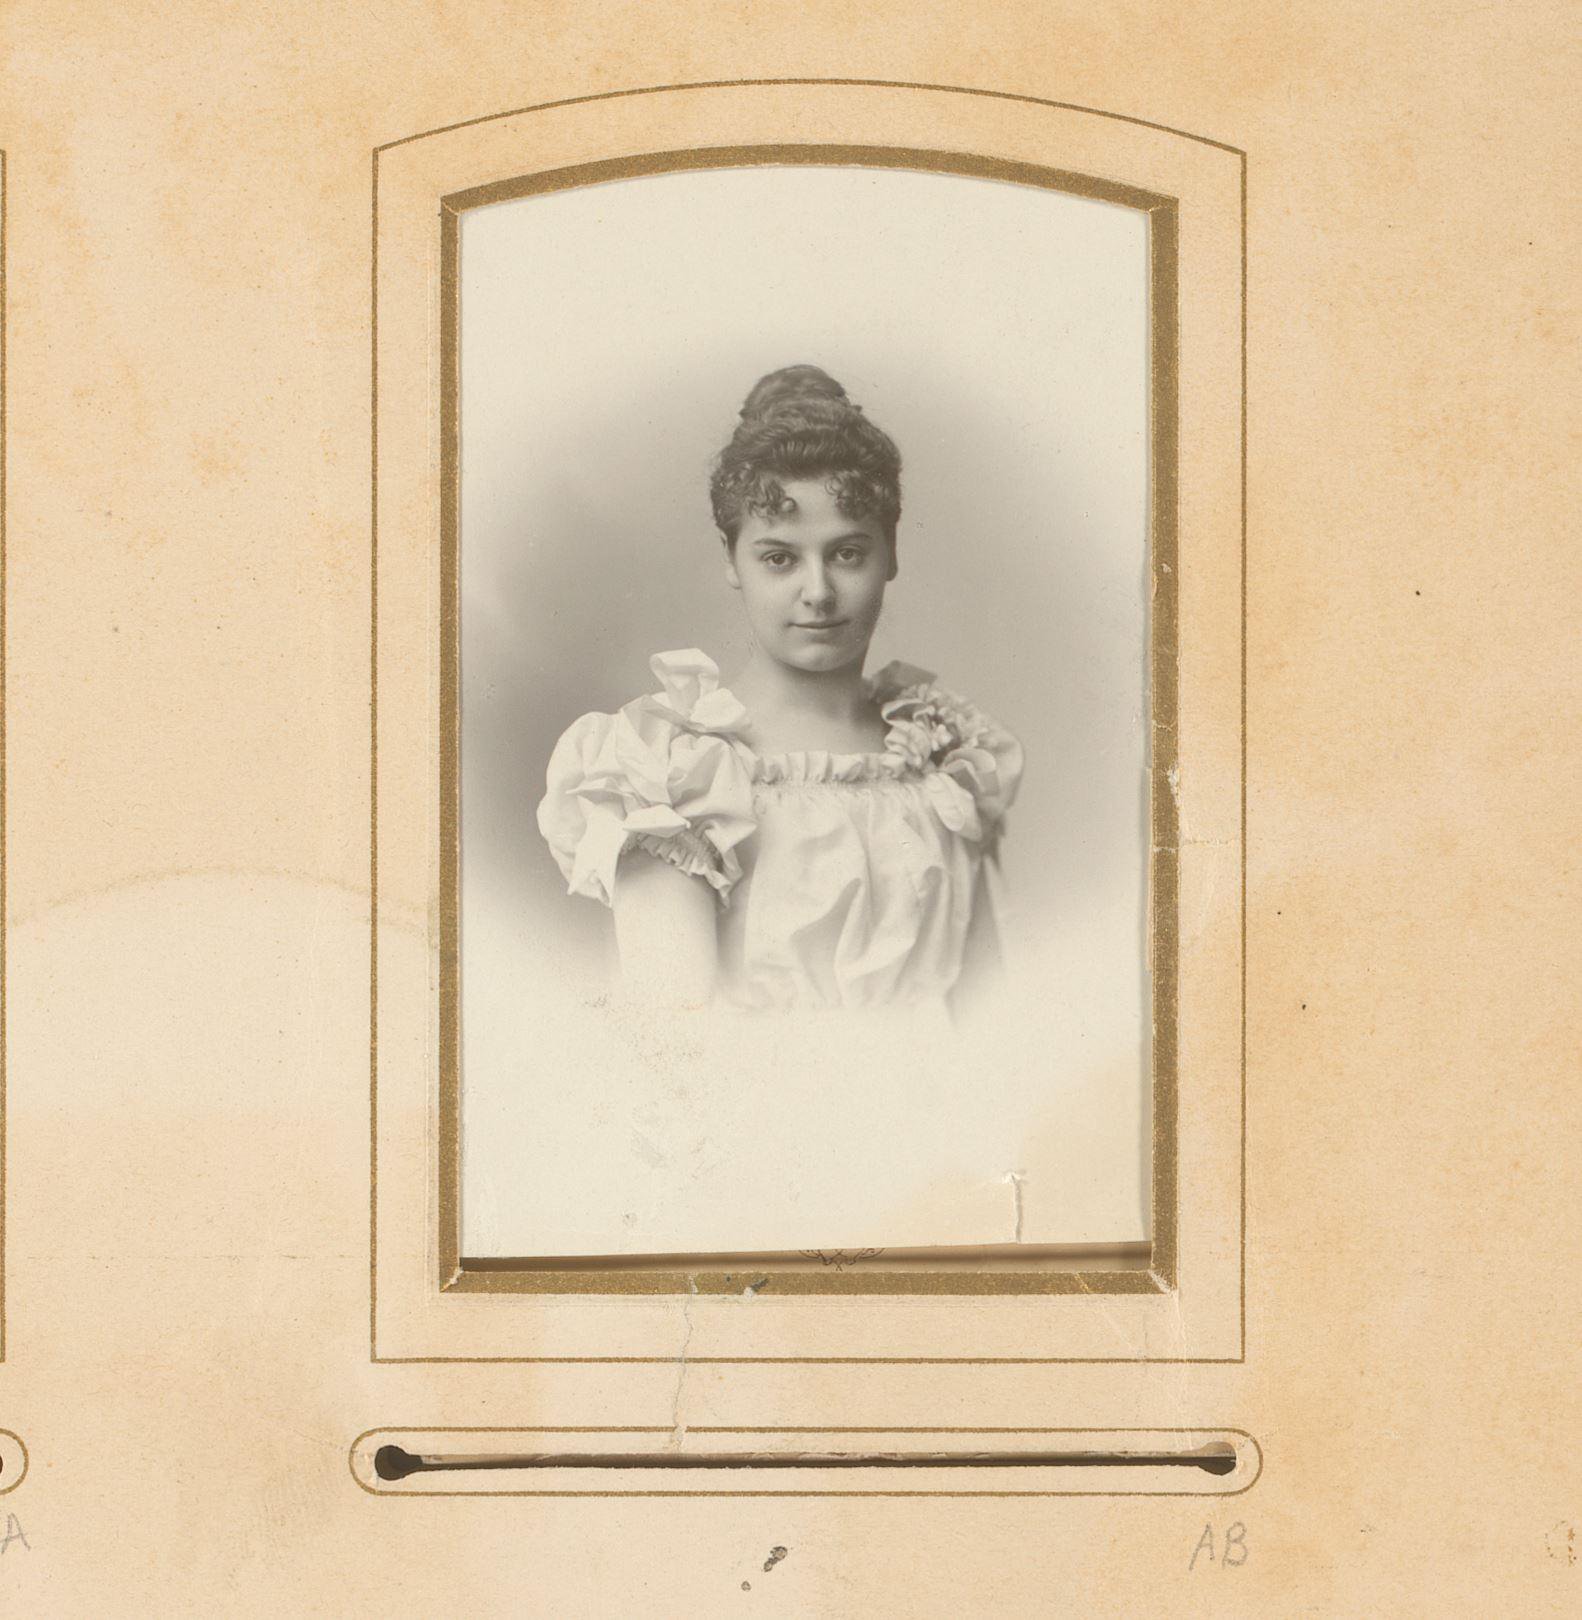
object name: carte de visite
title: Portret van een vrouw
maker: Anonymous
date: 1880-1920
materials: cardboard, photographic support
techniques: daylight paper print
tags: historical persons - bb - woman